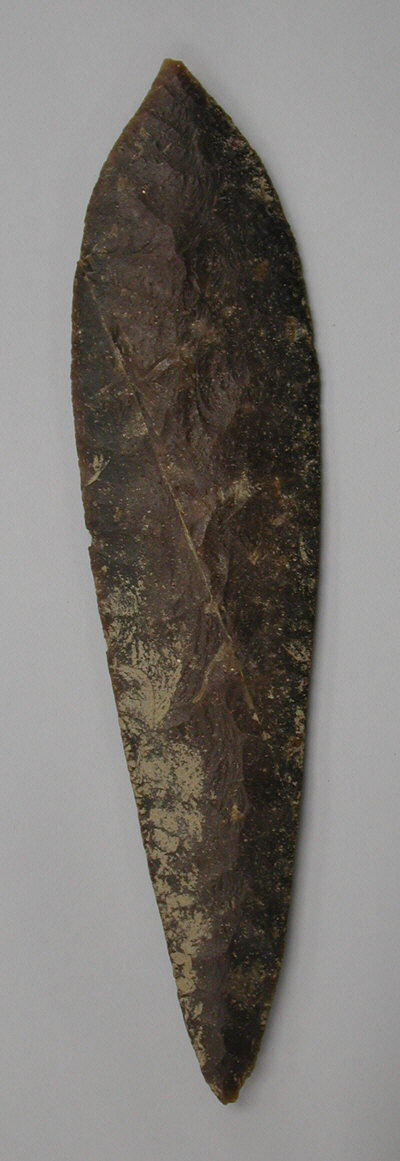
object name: knife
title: Flint Blade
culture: mexican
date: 1501-1600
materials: stone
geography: mexico